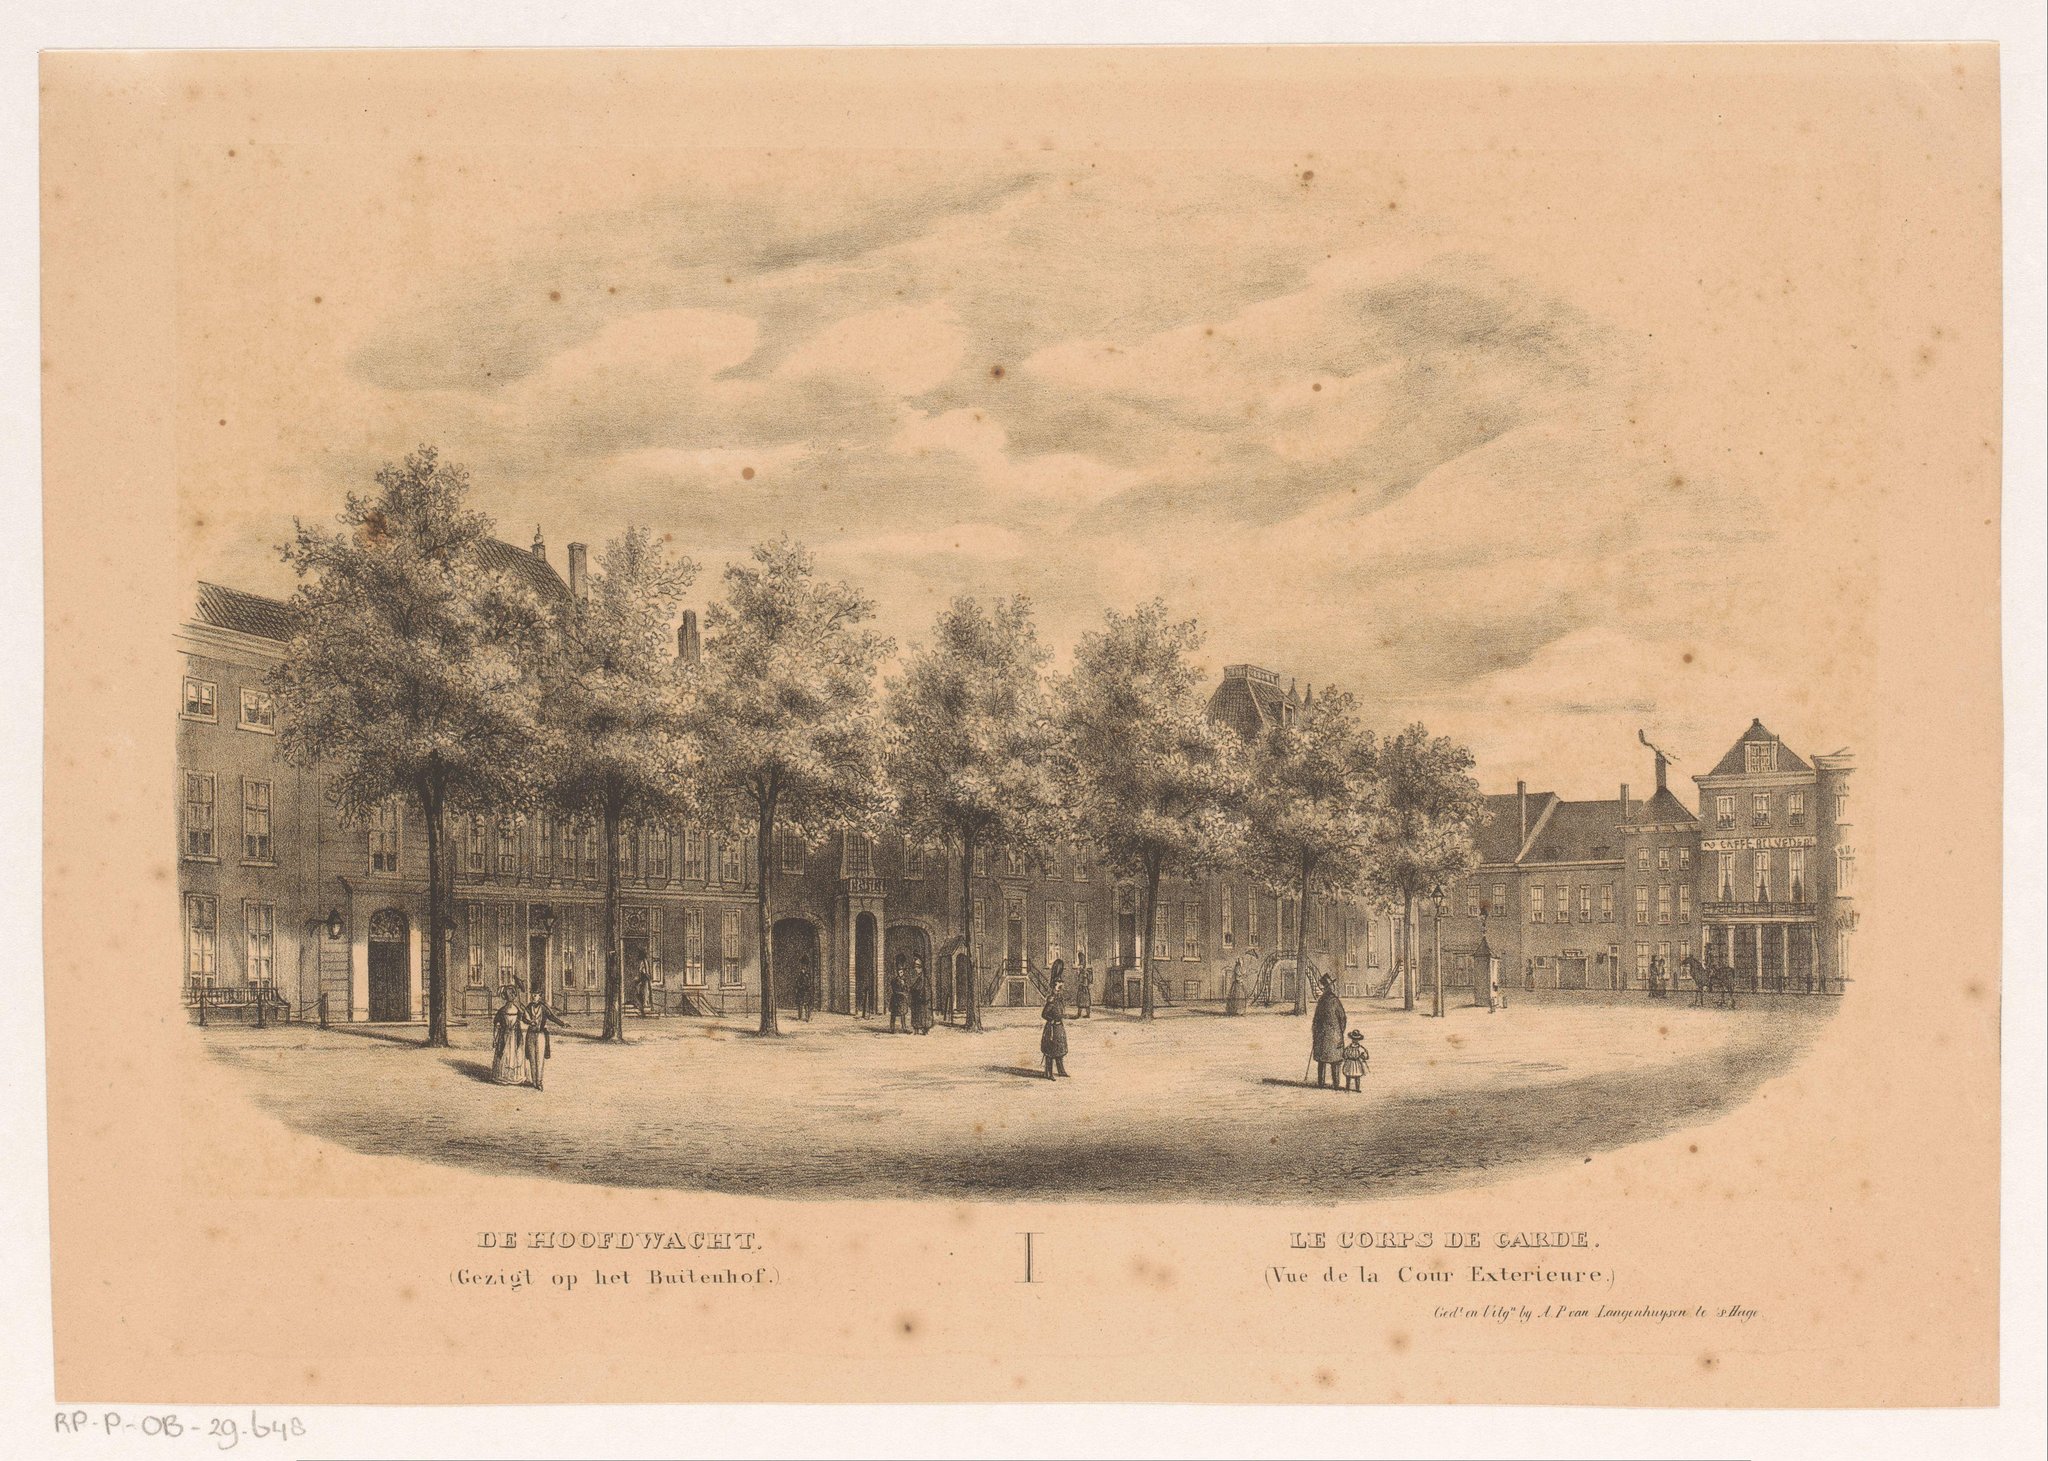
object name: print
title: De Hoofdwacht (Gezigt op het Buitenhof) / Le Corps de garde (Vue de la Cour Exterieur)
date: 1830-1846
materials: paper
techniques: tone lithography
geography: the hague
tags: guard duty, keeping sentry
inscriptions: collector's mark: Lugt 2228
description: Mensen op het Buitenhof met links midden de Hoofdwacht, het voormalig wachthuis van de ruiterwacht.